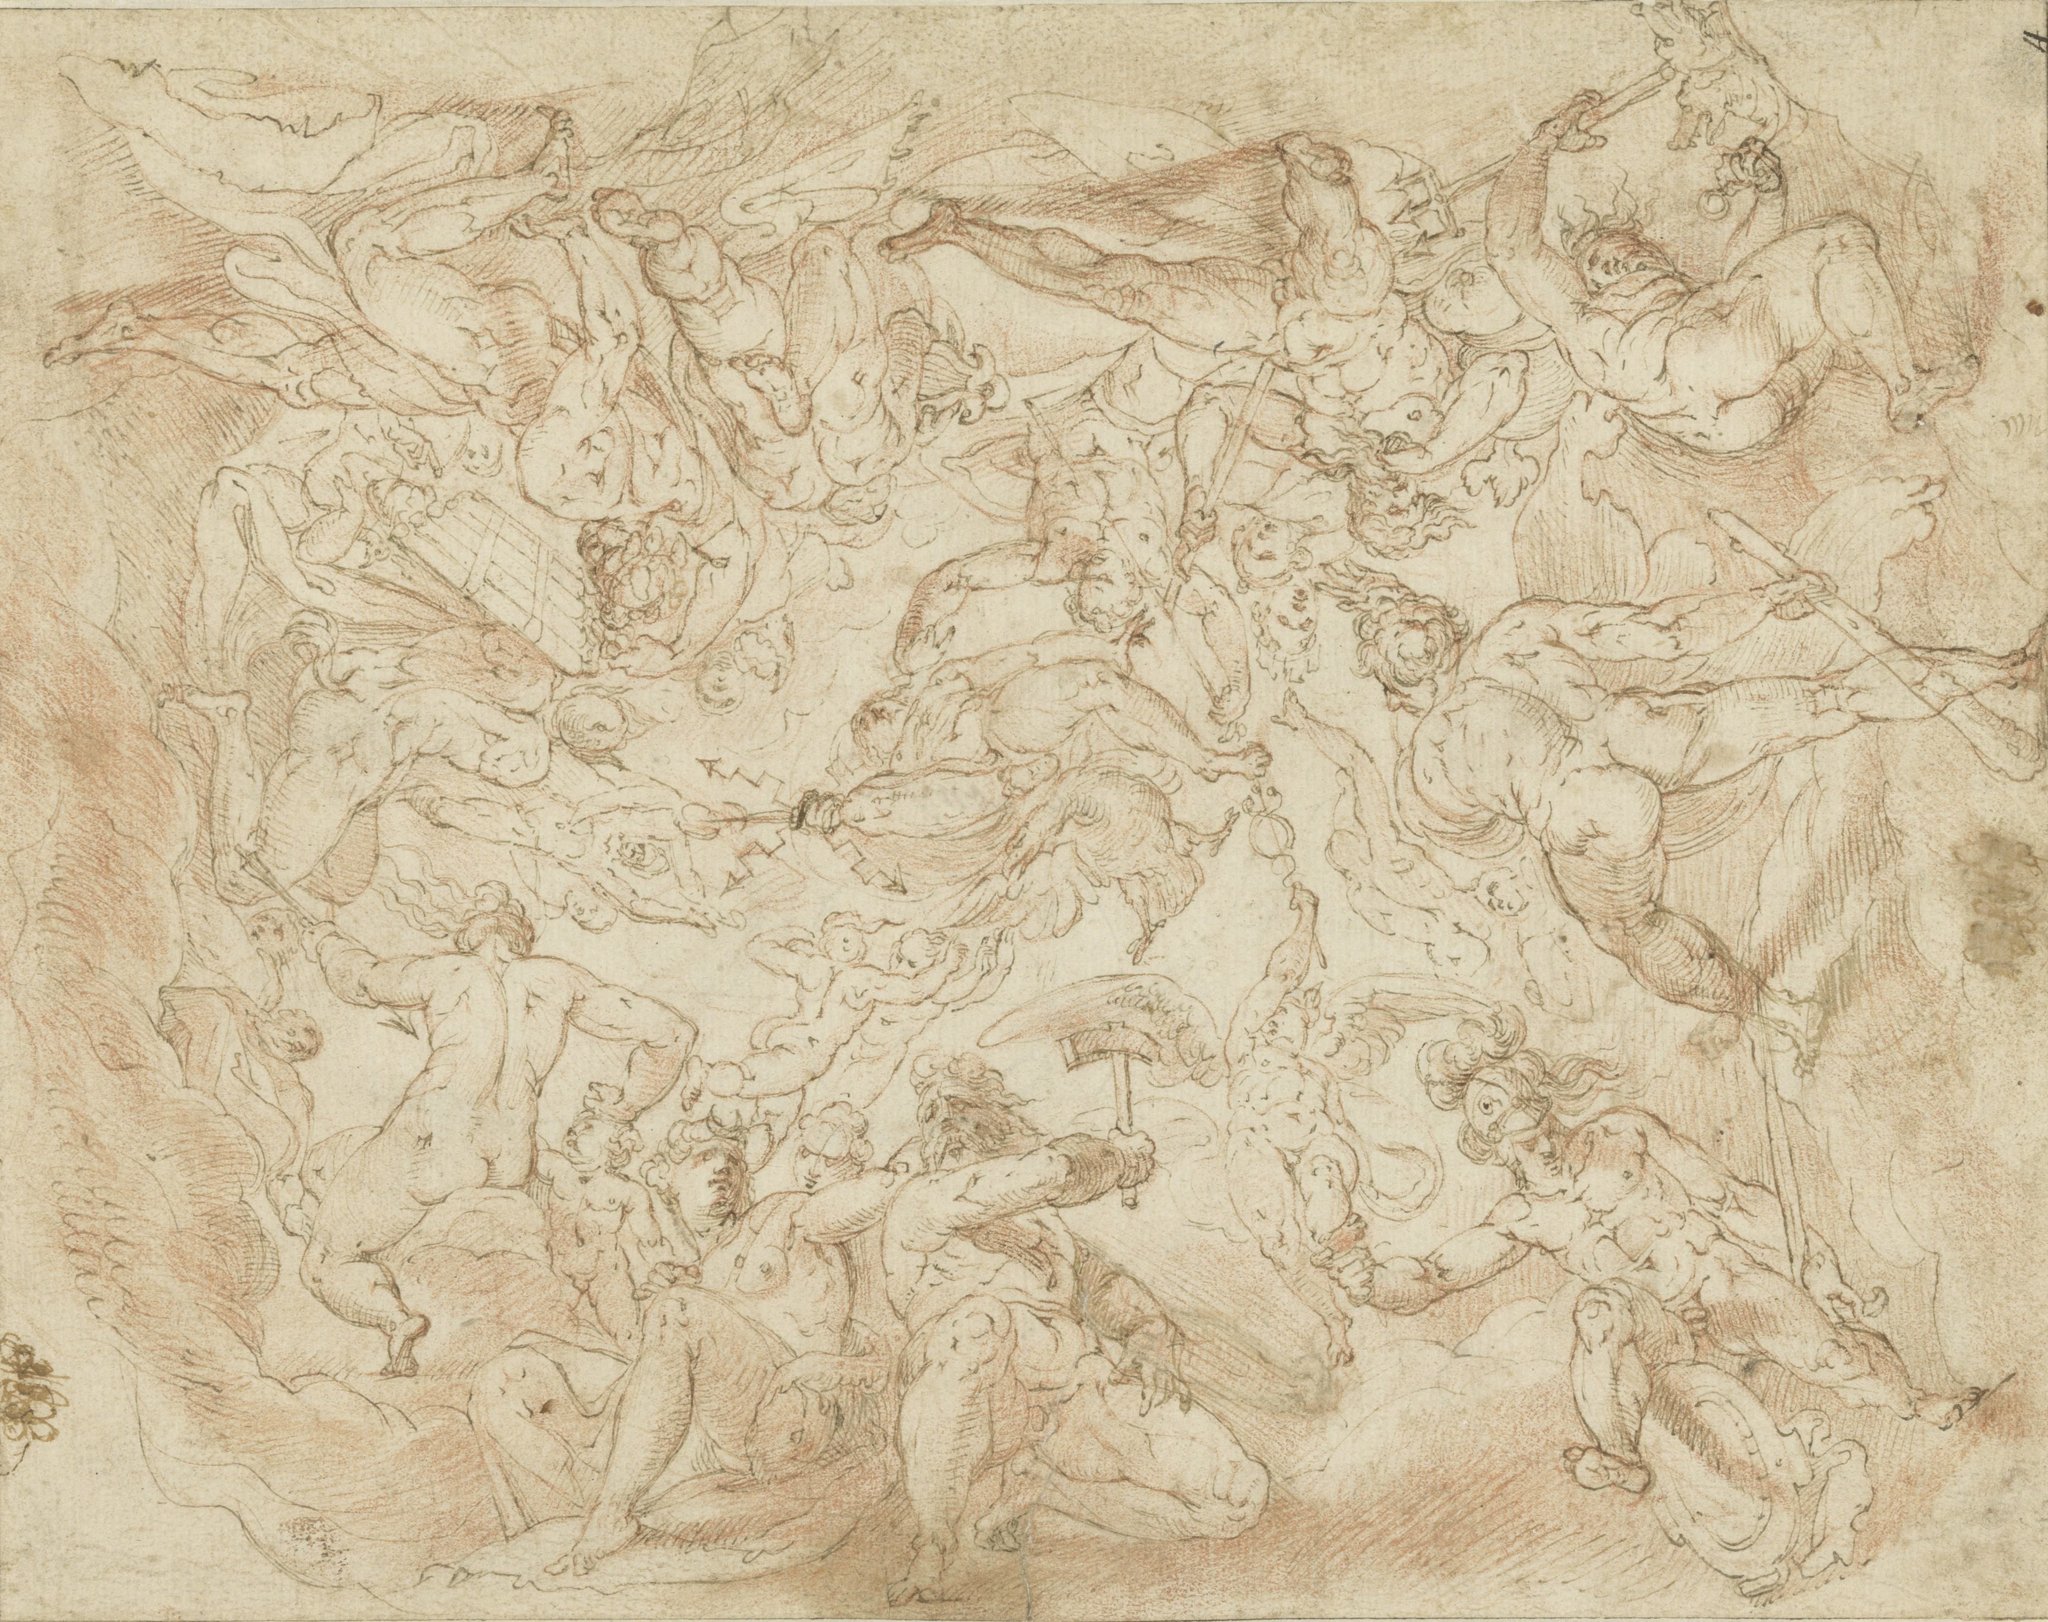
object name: drawing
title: Olympus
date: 1500-1600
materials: chalk, ink, paper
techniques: pen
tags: the olympian gods together: jupiter, juno, neptune, ceres, apollo, diana, mars, venus, mercury, minerva, vulcan, vesta (or bacchus)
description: De Olympus: ontwerp voor een plafondschildering.